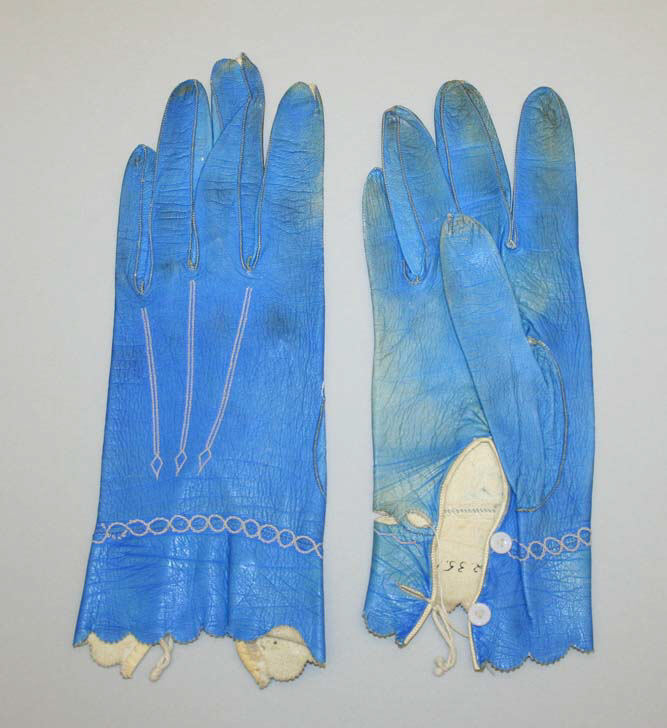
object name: glove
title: Gloves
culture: french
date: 1867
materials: leather